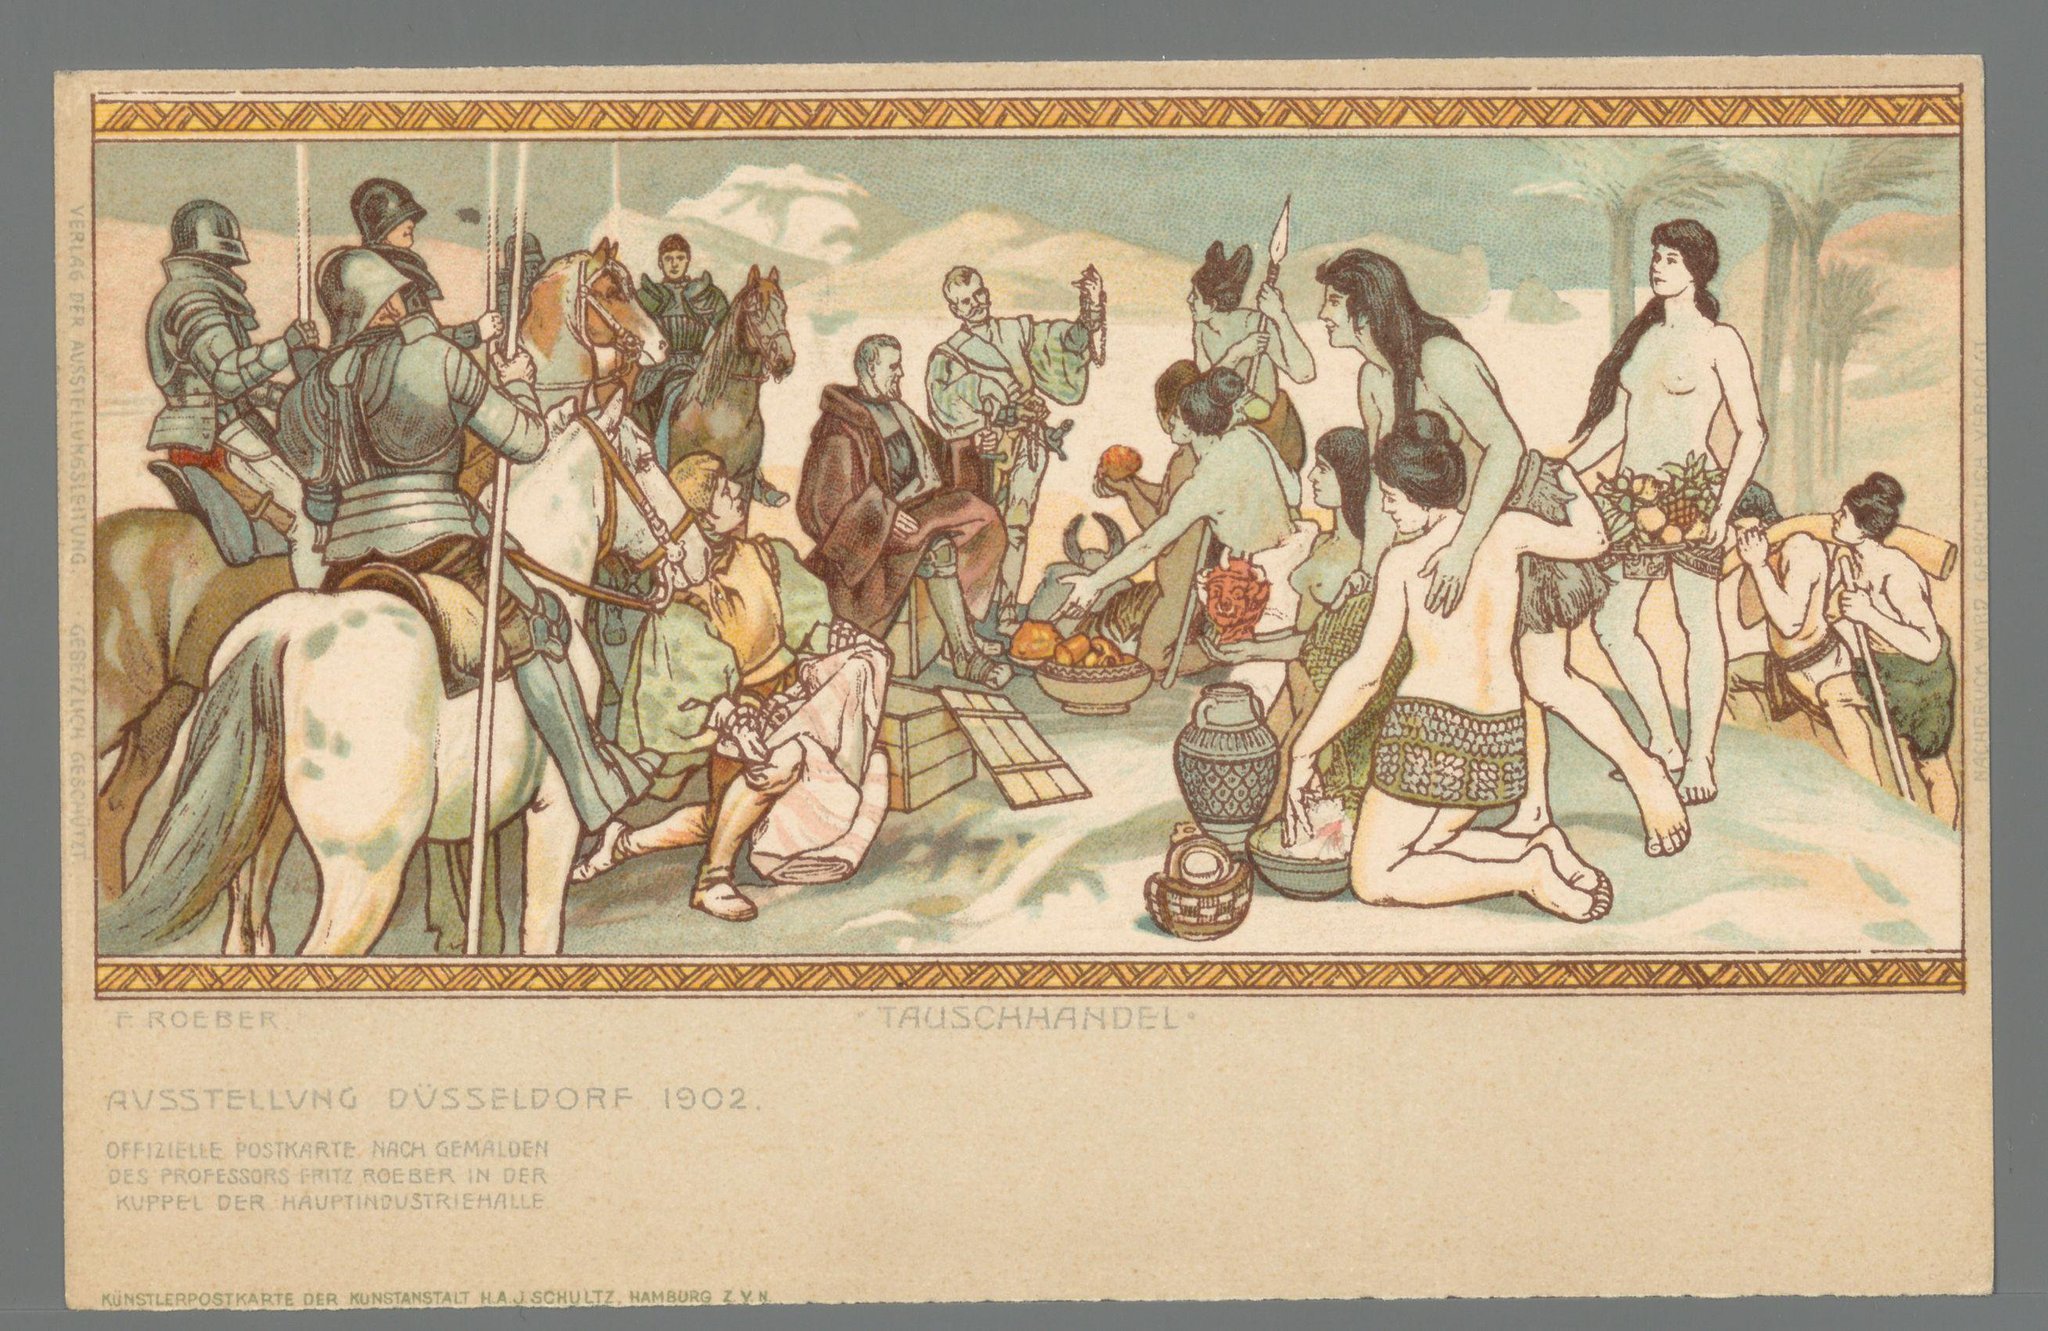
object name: ansichtkaart, prentbriefkaart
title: Tauschhandel. Ausstellung Düsseldorf 1902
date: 1902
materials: cardboard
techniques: lithograph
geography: hamburg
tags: barter, temporary exhibition, 'salon'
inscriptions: date